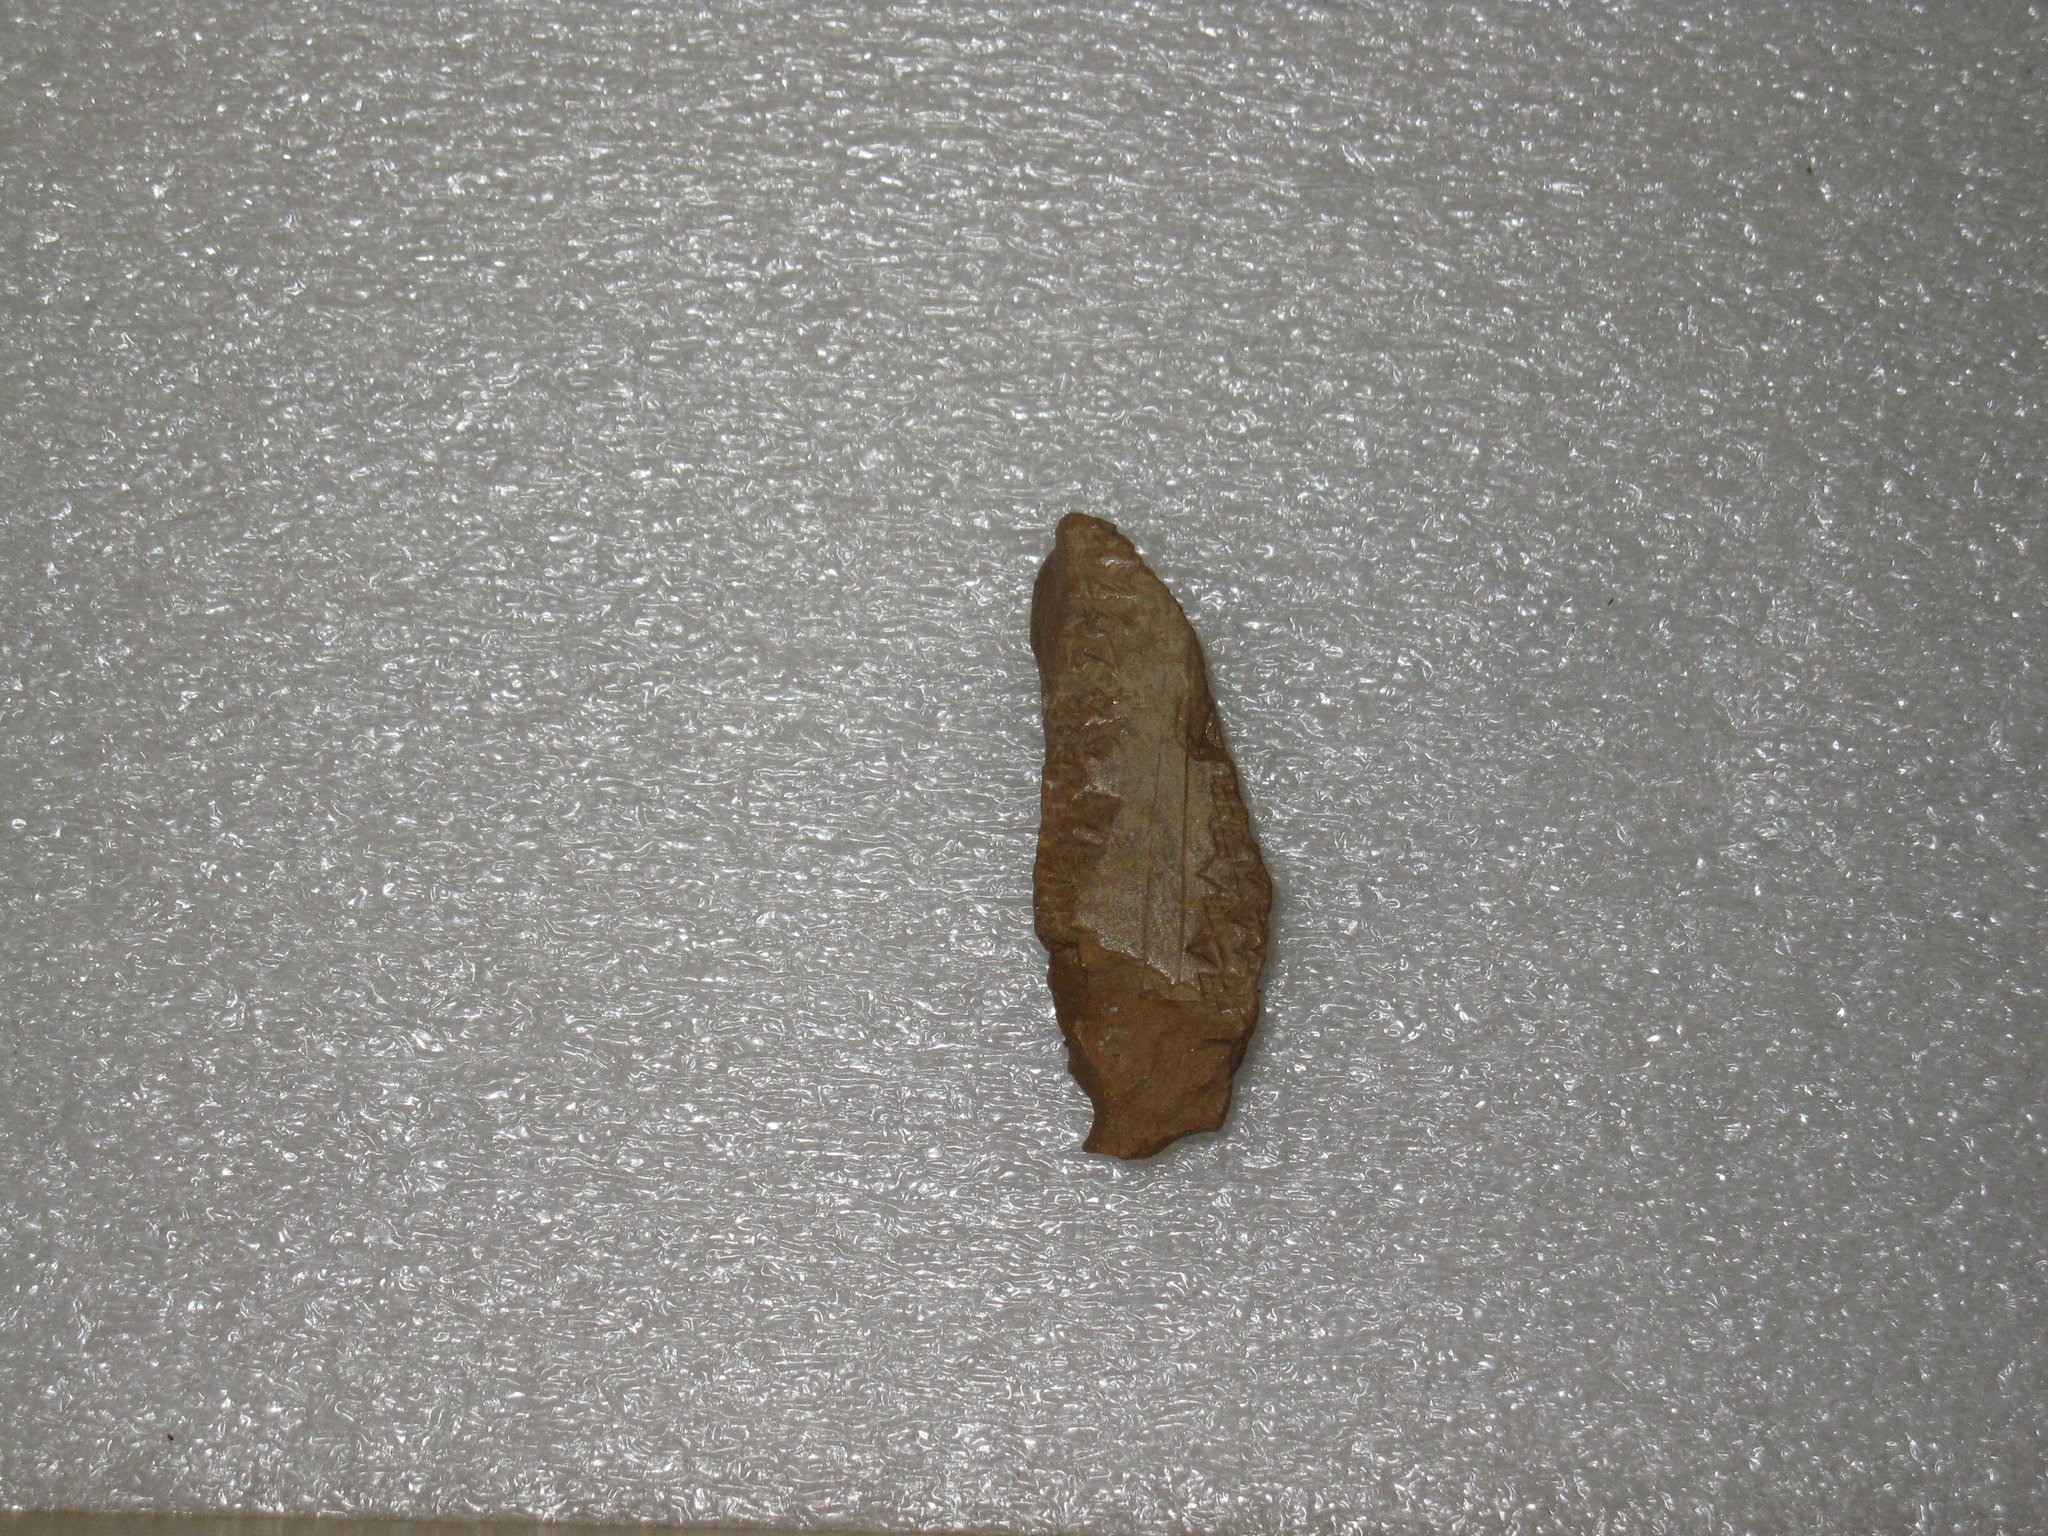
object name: cuneiform tablet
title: Cuneiform tablet: fragment of a table containing numbers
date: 333-1 BCE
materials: clay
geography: mesopotamia